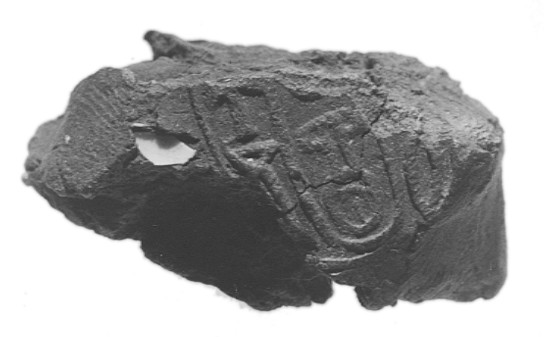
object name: sealing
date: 2030-1640 BCE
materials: clay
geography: egypt